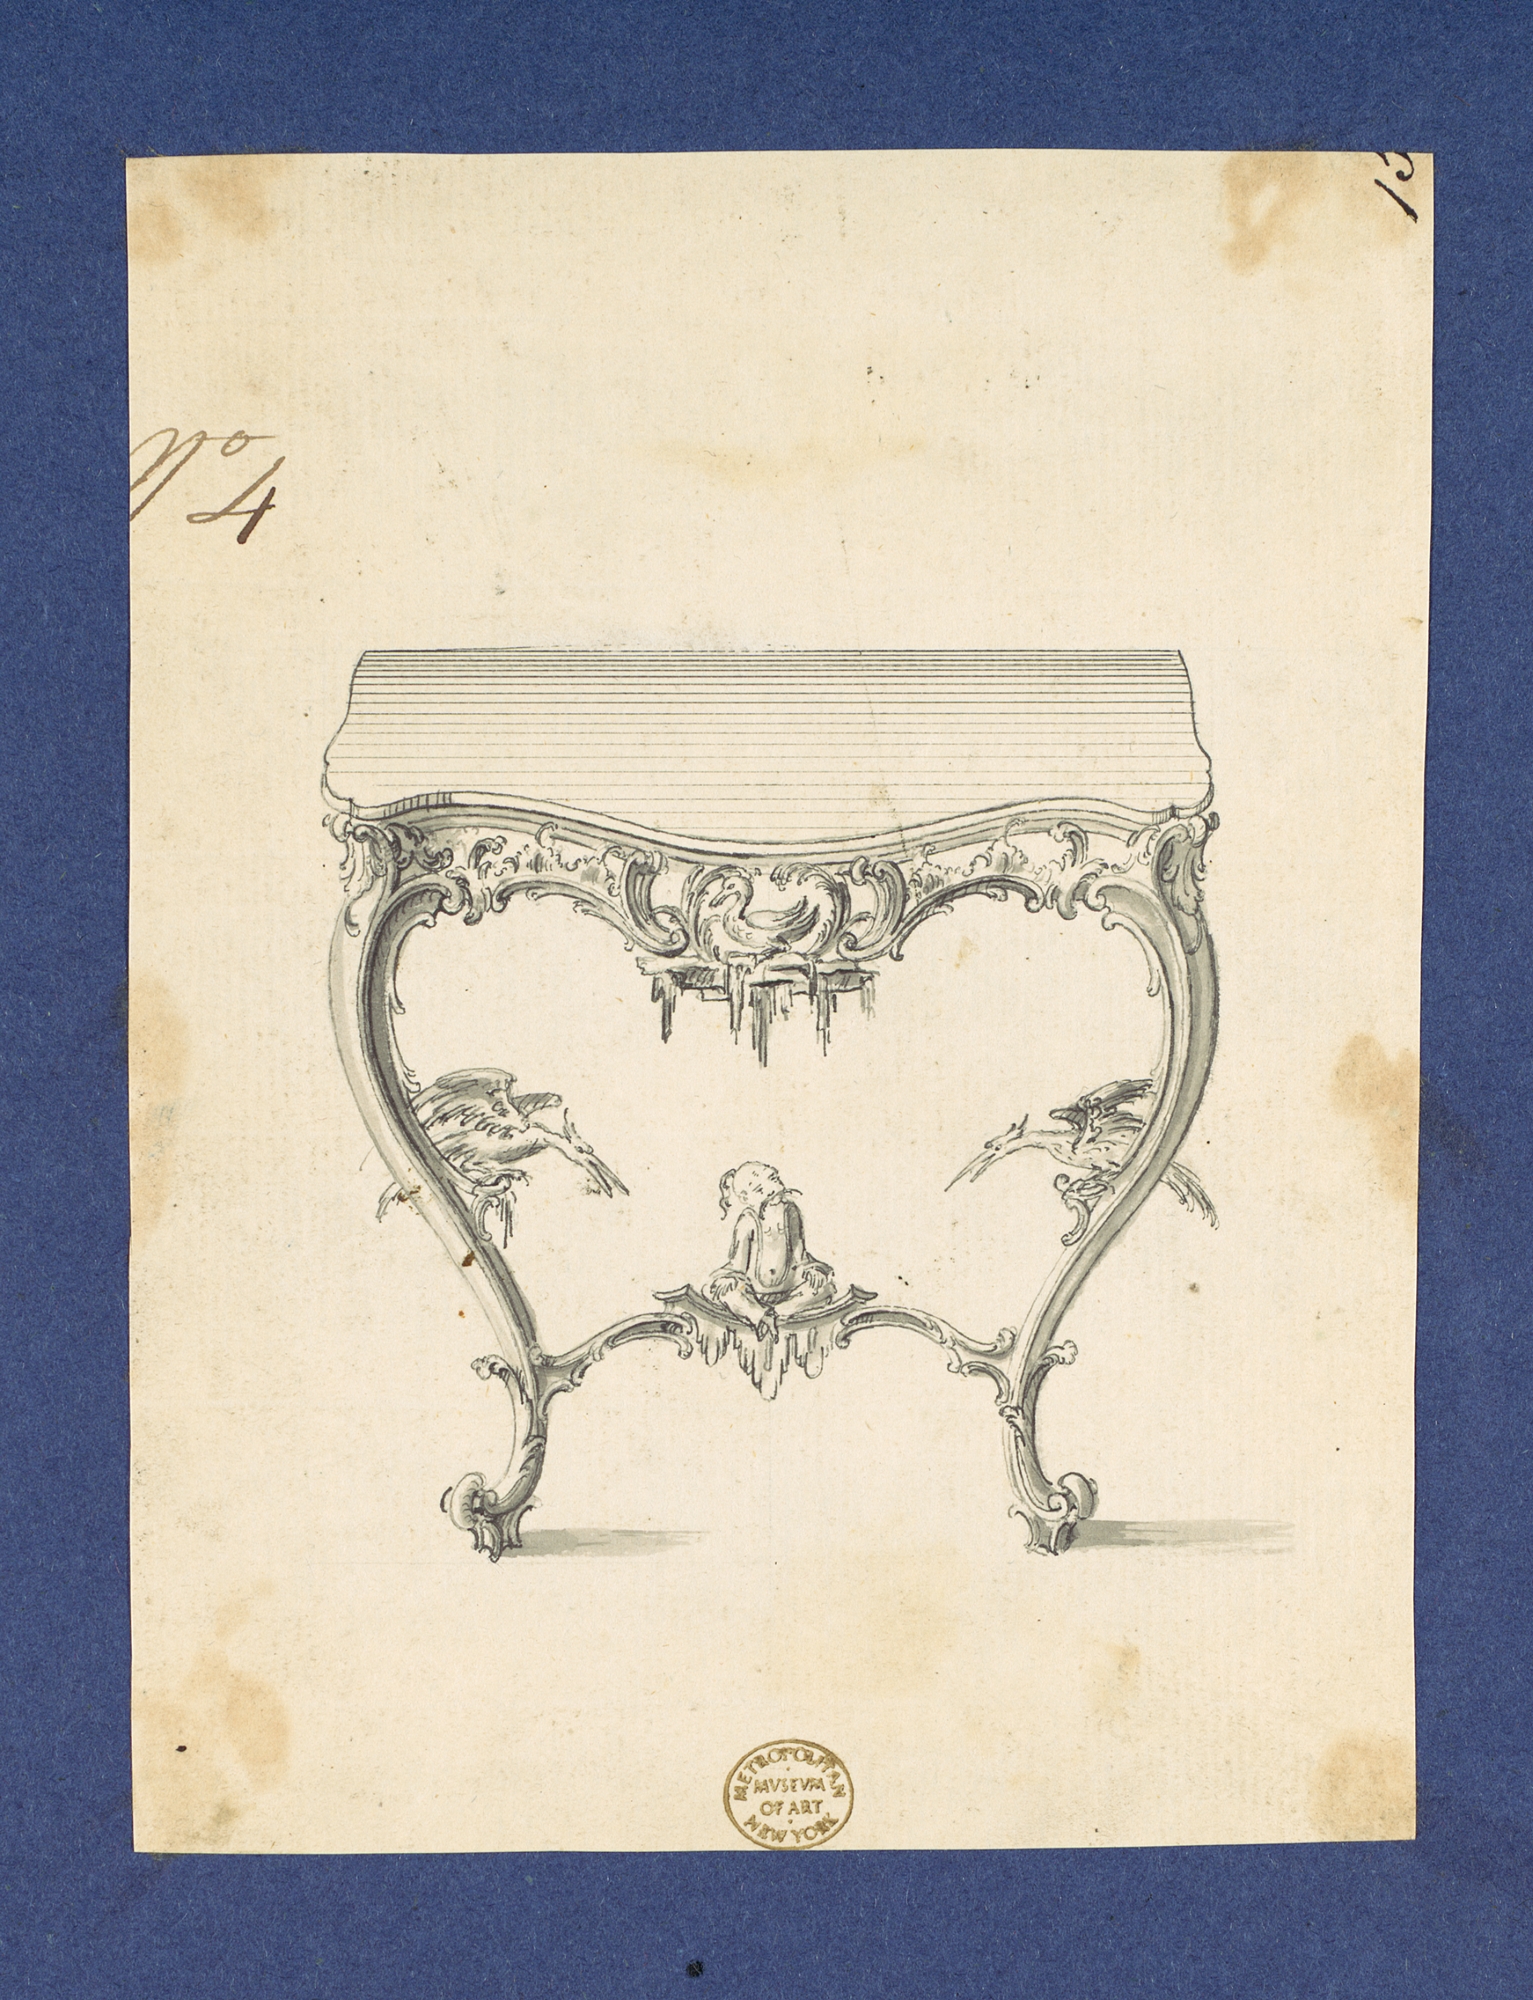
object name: drawing ornament architecture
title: Sideboard Table, in Chippendale Drawings, Vol. I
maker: thomas chippendale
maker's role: artist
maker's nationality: british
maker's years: 1718-1779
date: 1760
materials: ink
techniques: wash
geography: london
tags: birds,tables